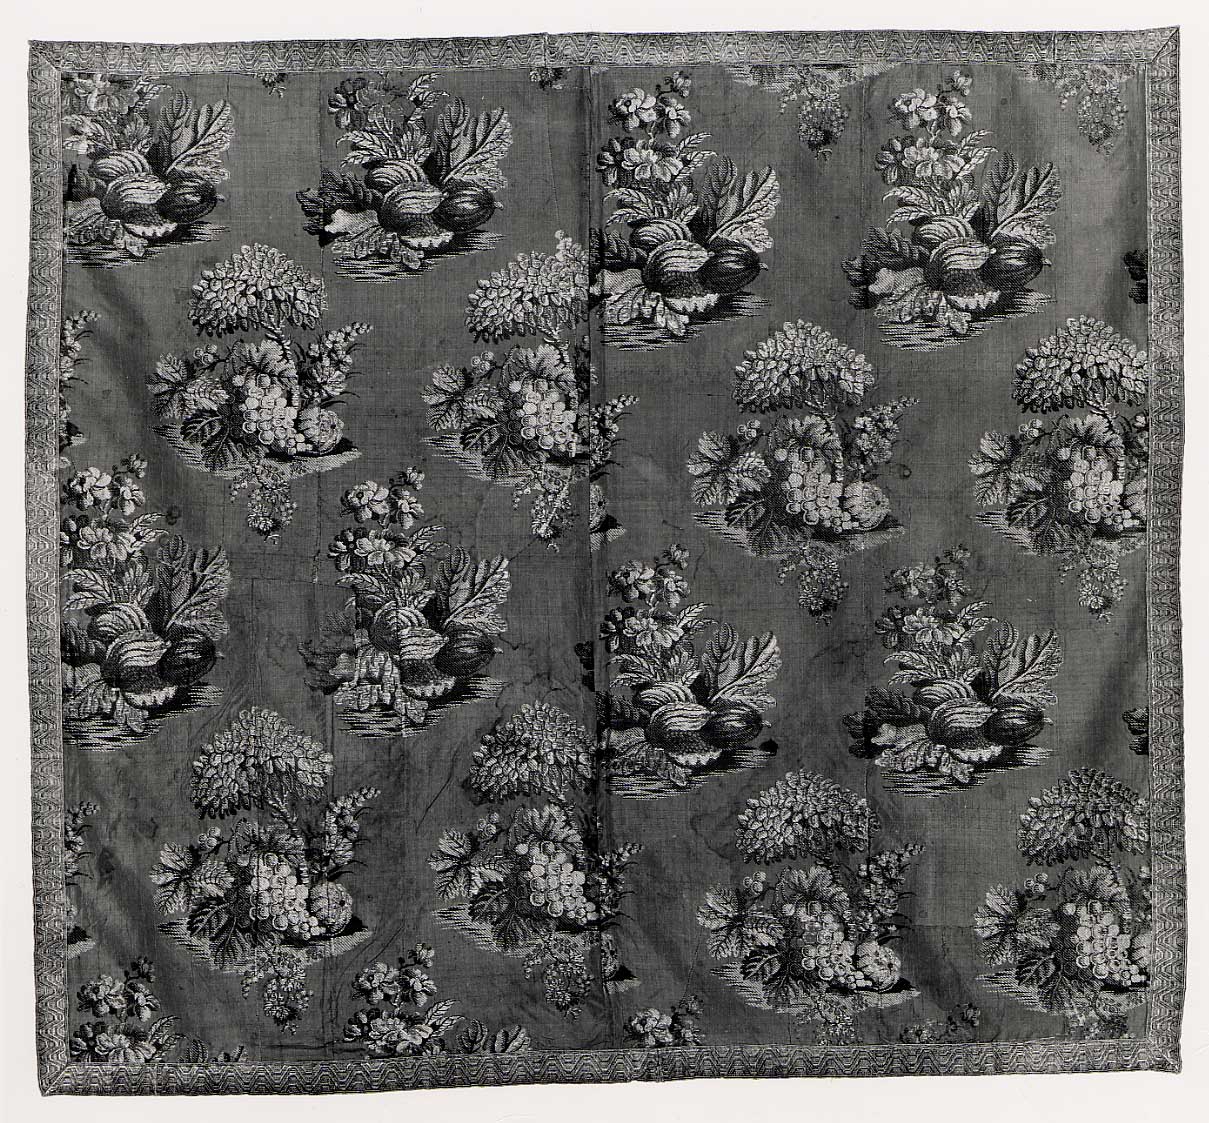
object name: textile cover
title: Cover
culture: french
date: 1730-1739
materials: cotton, metal, silk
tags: grapes